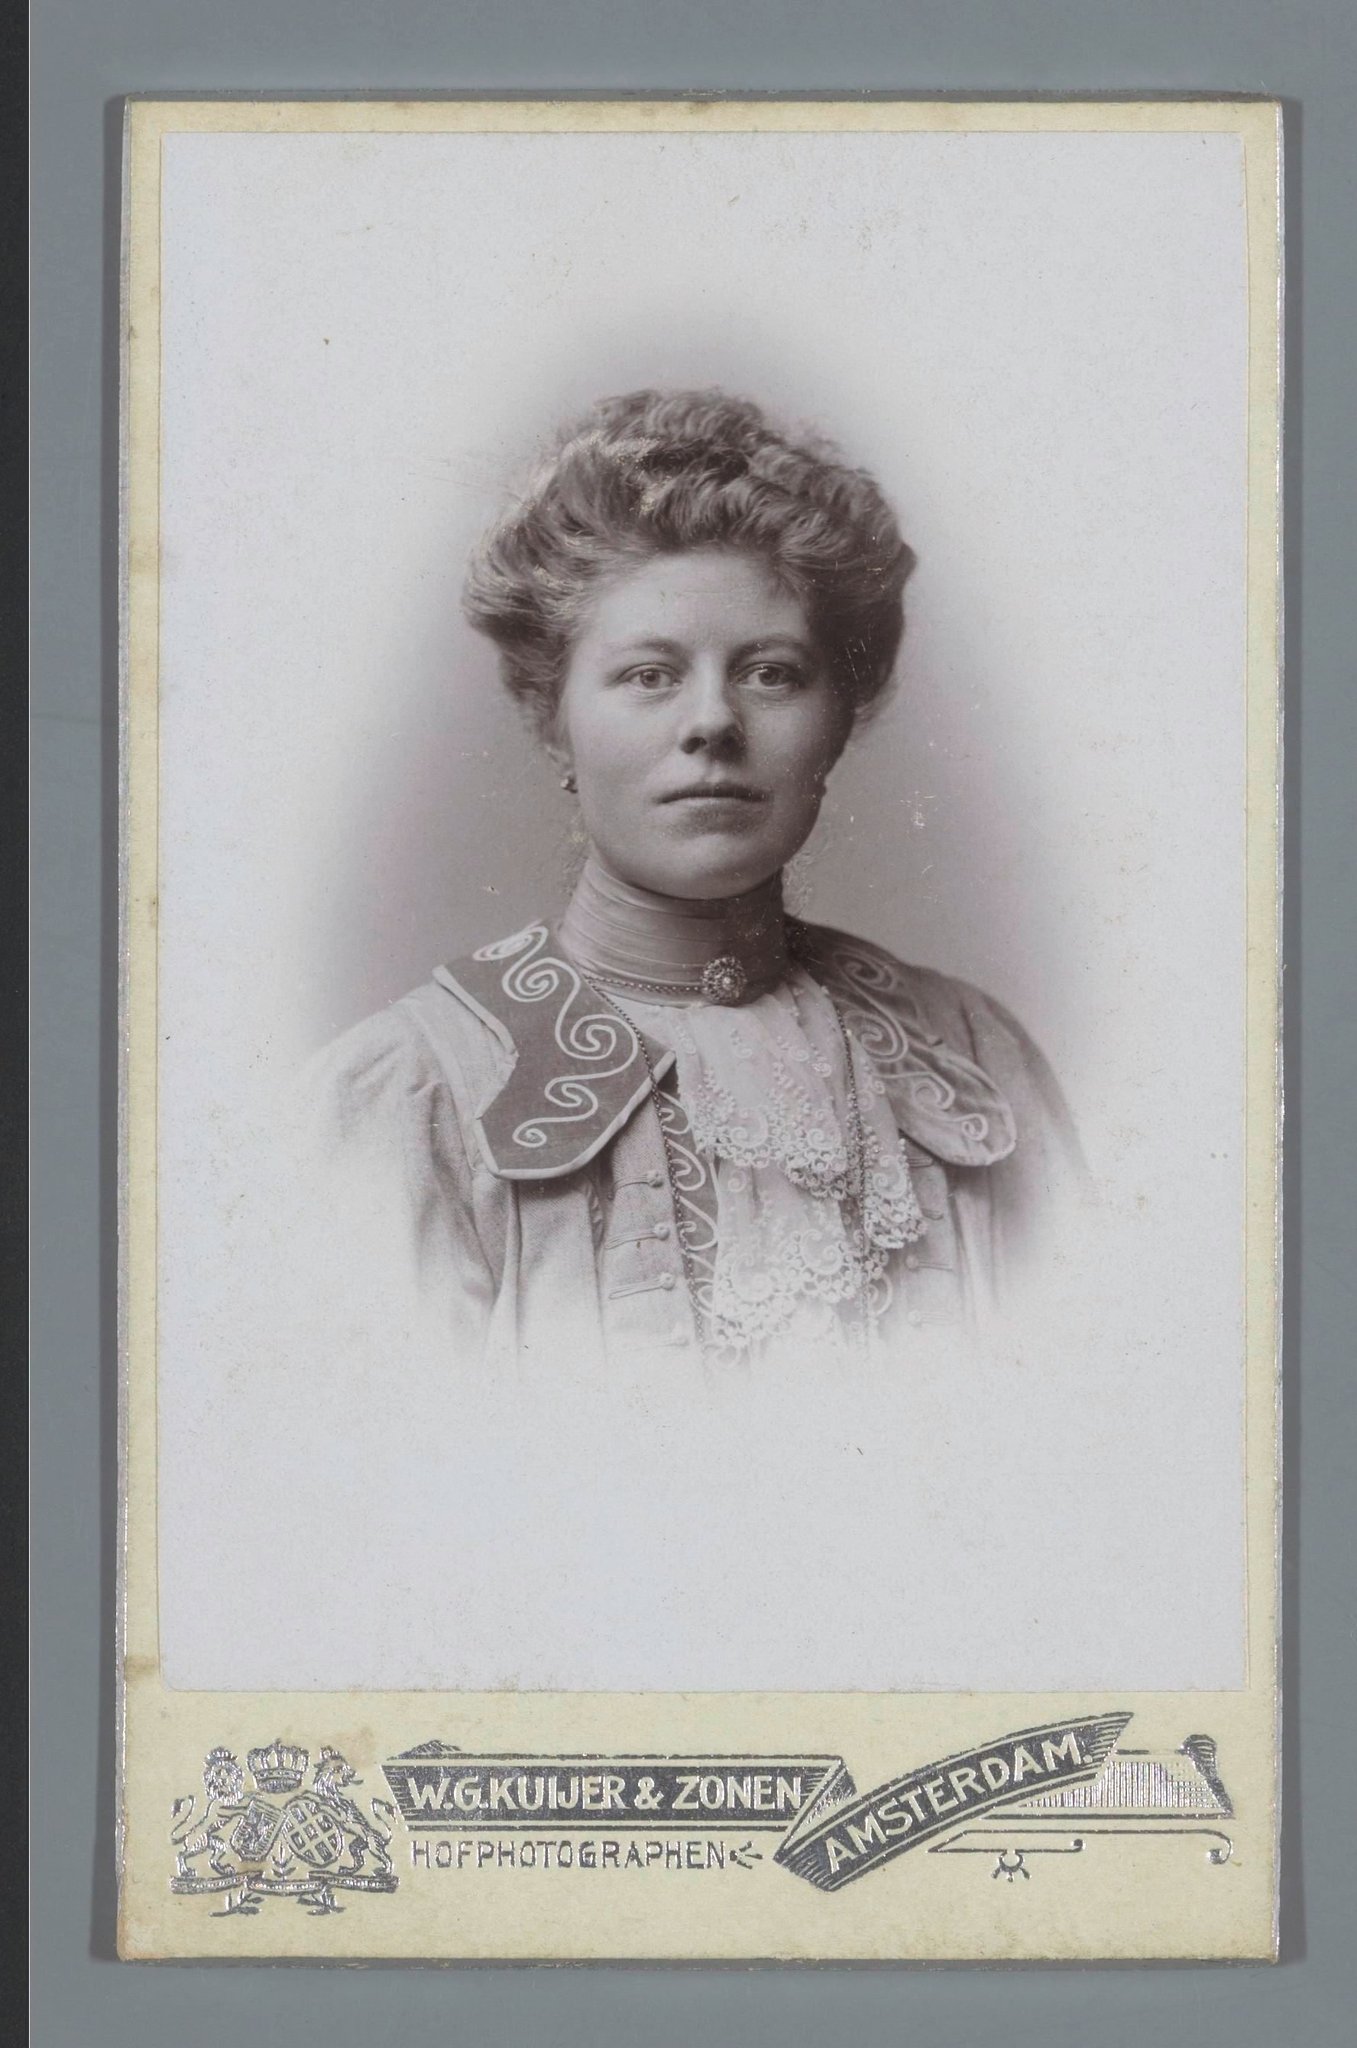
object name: photograph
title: Portret van een onbekende vrouw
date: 1885-1906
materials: cardboard, photographic support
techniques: collodion silver print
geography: amsterdam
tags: historical persons - bb - woman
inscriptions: inscription: ‘OPGERICHT 1864/ W. G. Kuijer & Zonen/ Hofphotographen/ WESTERMARKT 19./ AMSTERDAM/ Spéciale Inrichting voor Vergrootingen in alle Formaten.’